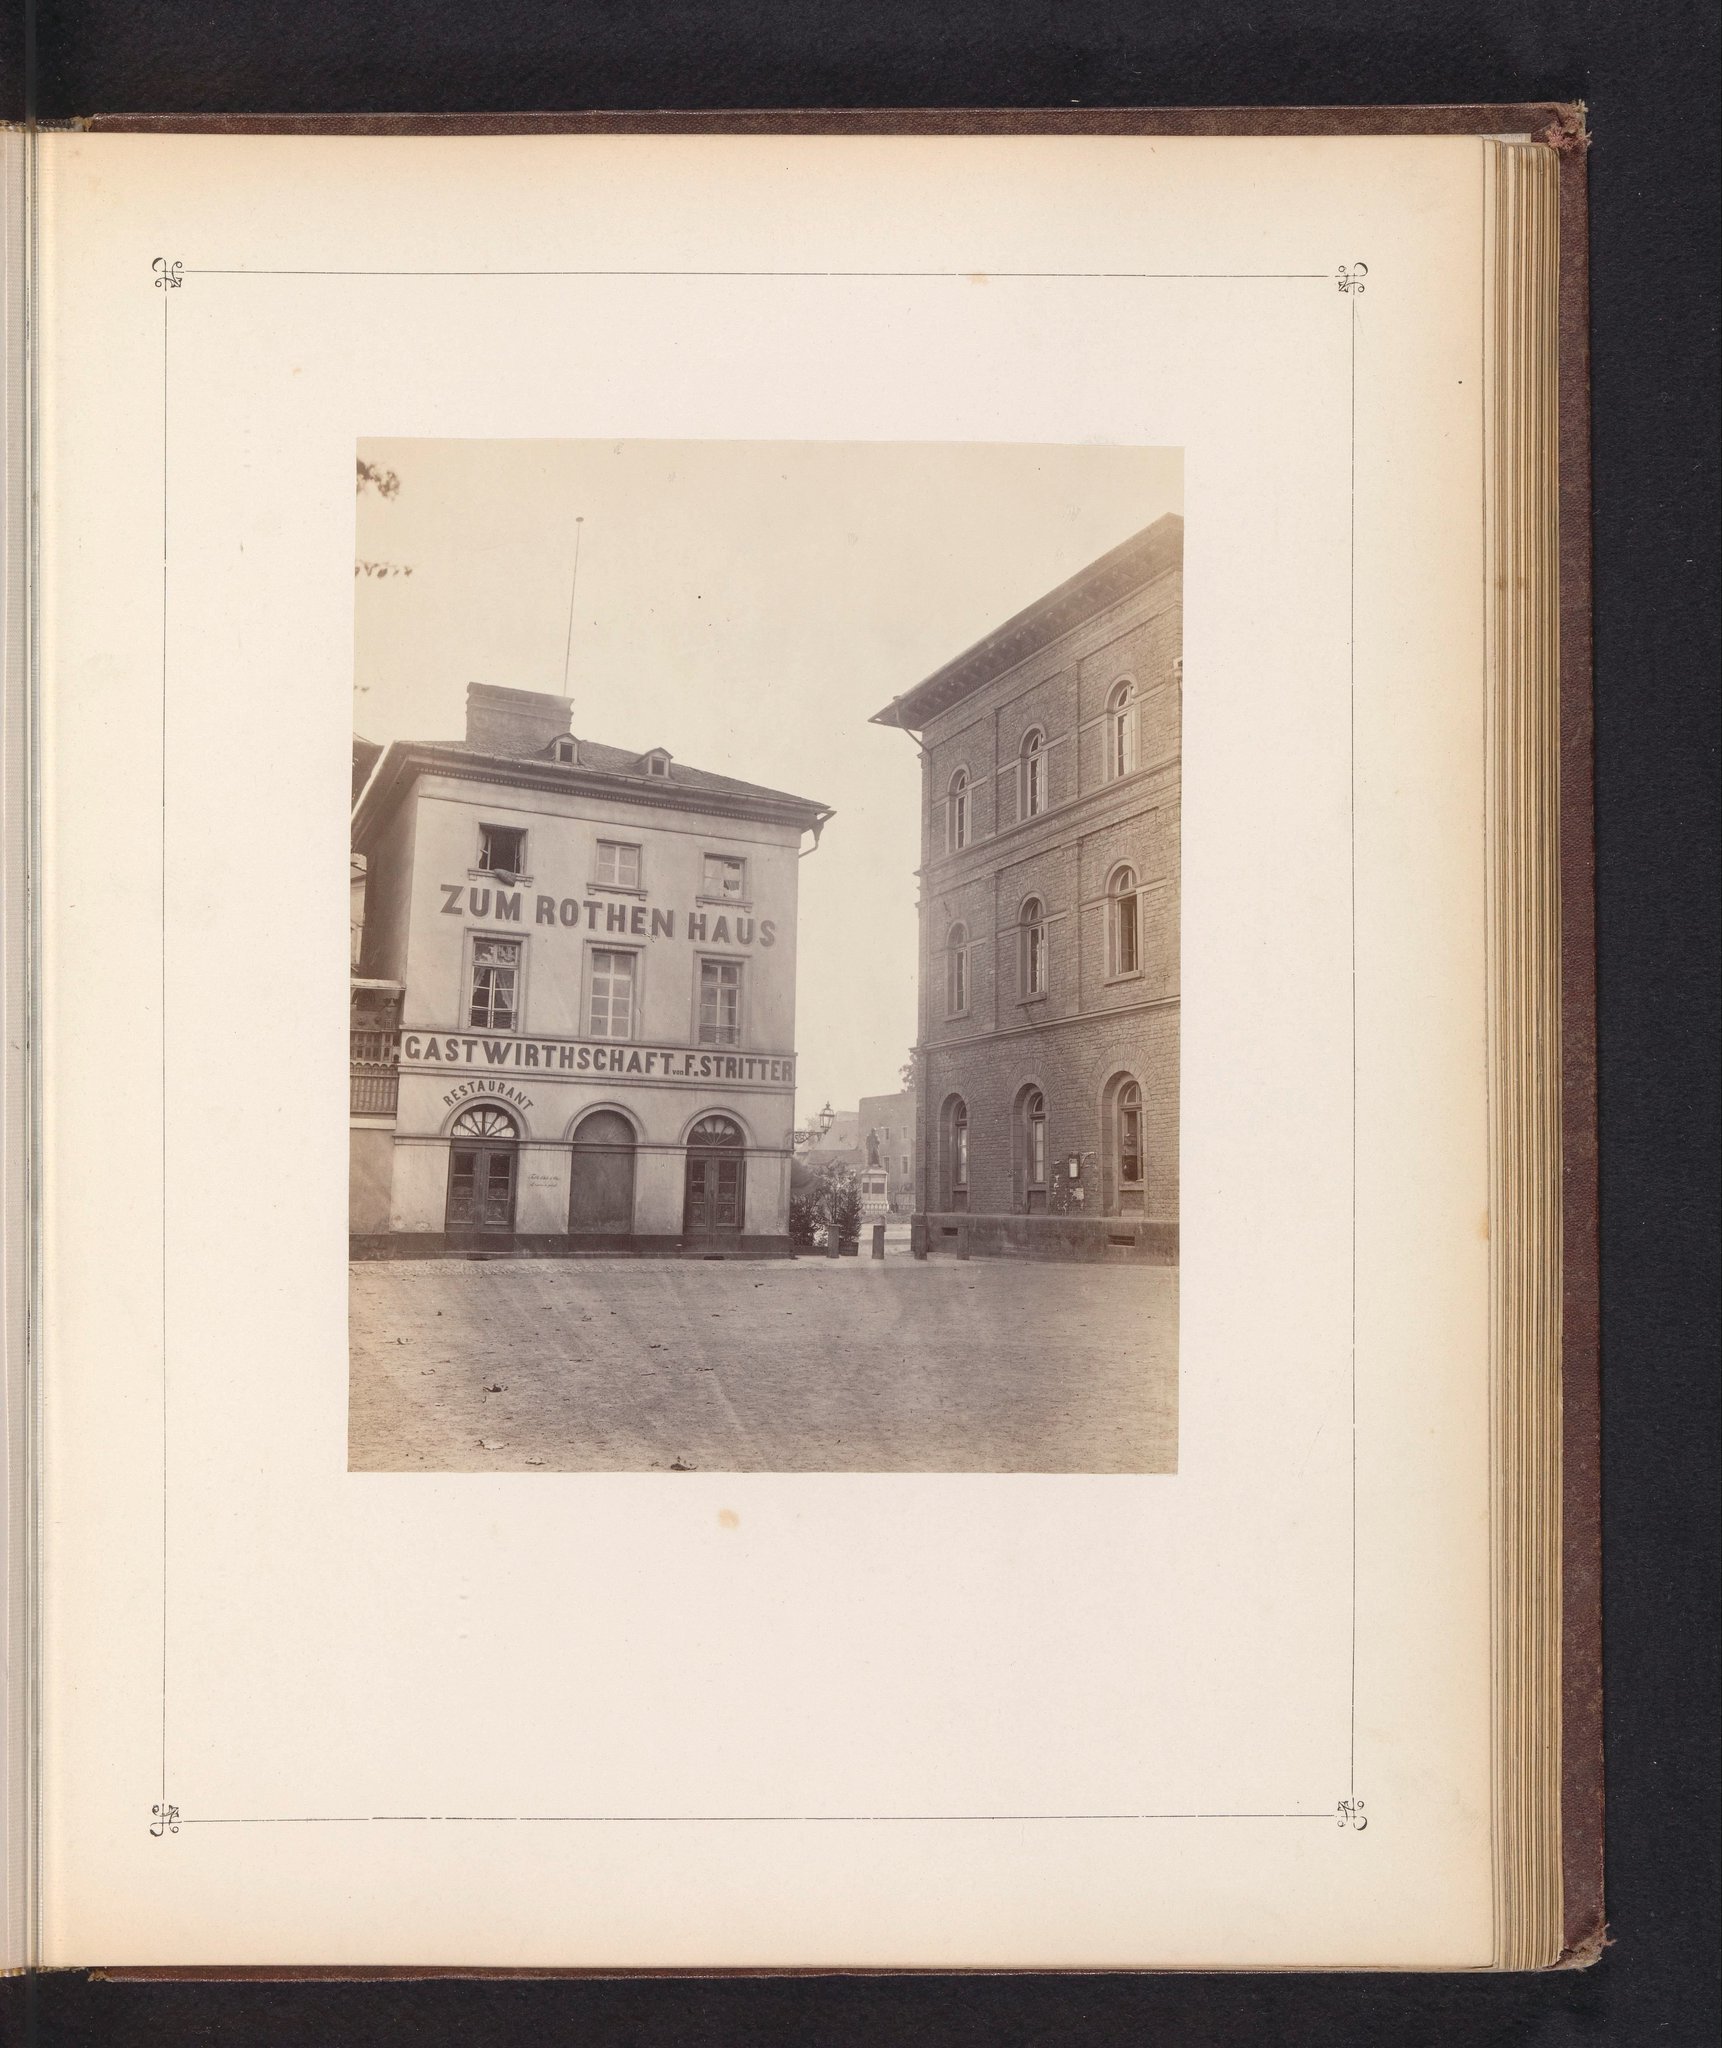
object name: page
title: Plein te Mainz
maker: b. erdmann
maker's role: fotograaf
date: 1867-1872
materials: photographic support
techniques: albumen print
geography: mainz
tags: village square, place